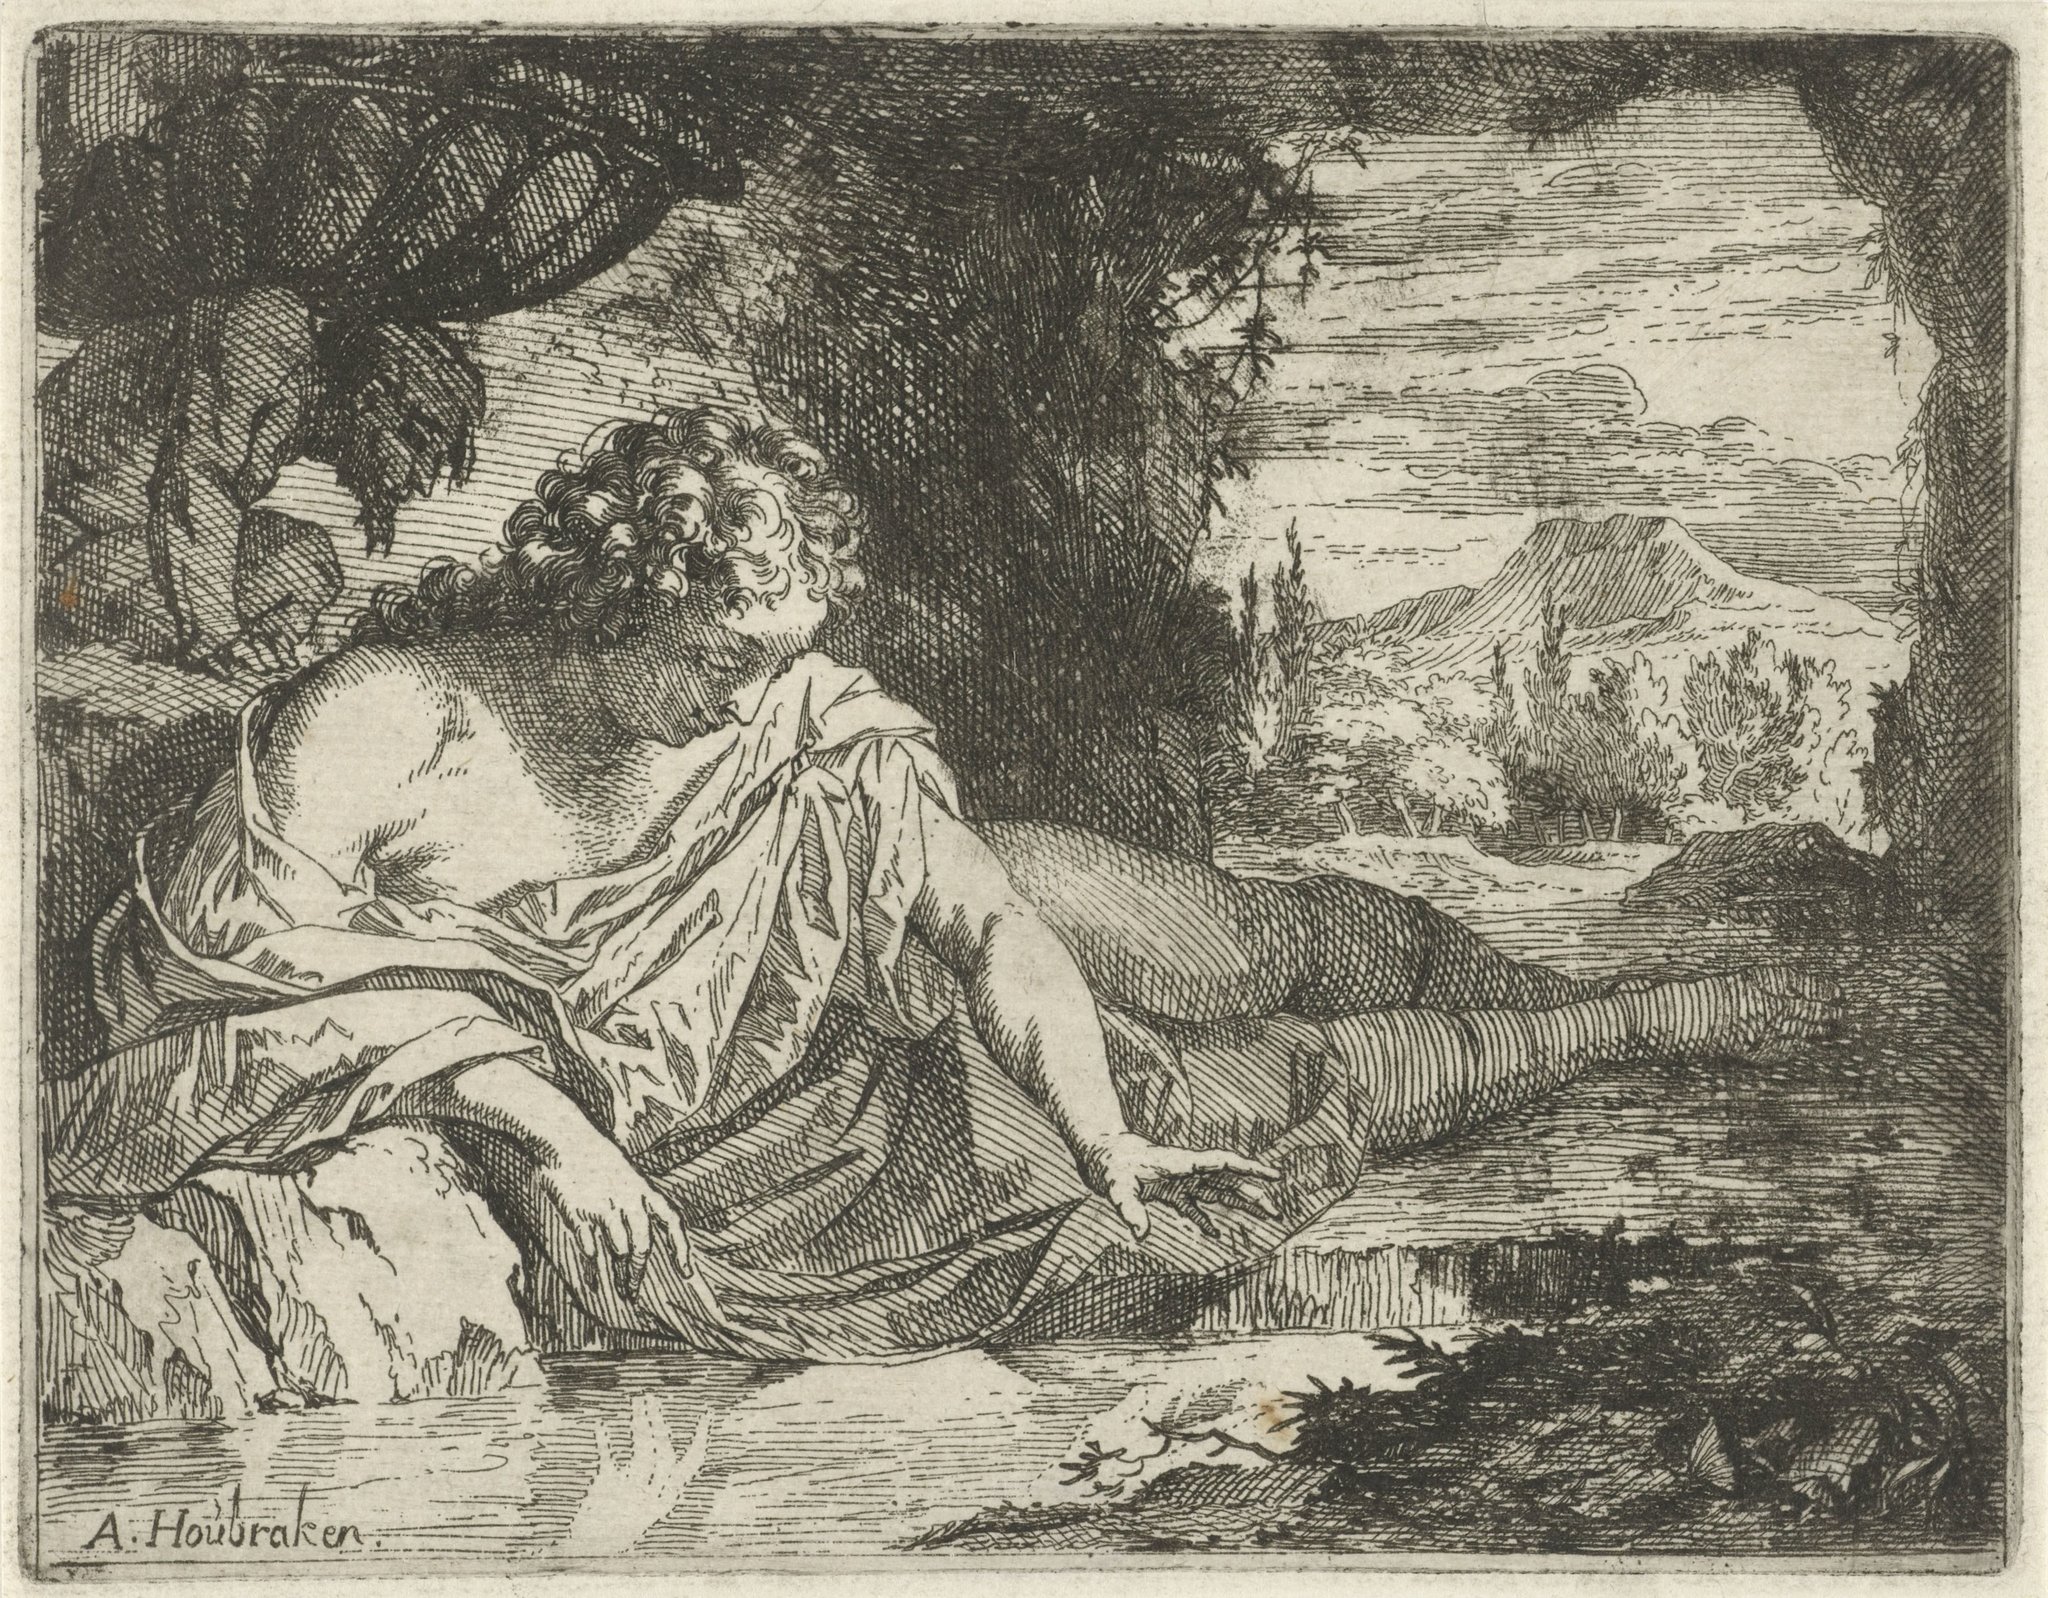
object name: print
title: Narcissus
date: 1688-1700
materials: paper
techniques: etching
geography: dordrecht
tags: narcissus, gazing in a fountain, falls in love with his own reflection; possibly the nymph echo peeps at the scene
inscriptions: collector's mark: Lugt 2228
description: Narcissus kijkt in een grot naar zijn eigen reflectie in het water. Op de achtergrond een berglandschap. Prent van deel 2 van een serie prenten met zinnebeelden, in totaal bestaande uit drie delen met respectievelijk 23, 17 en 20 prenten.